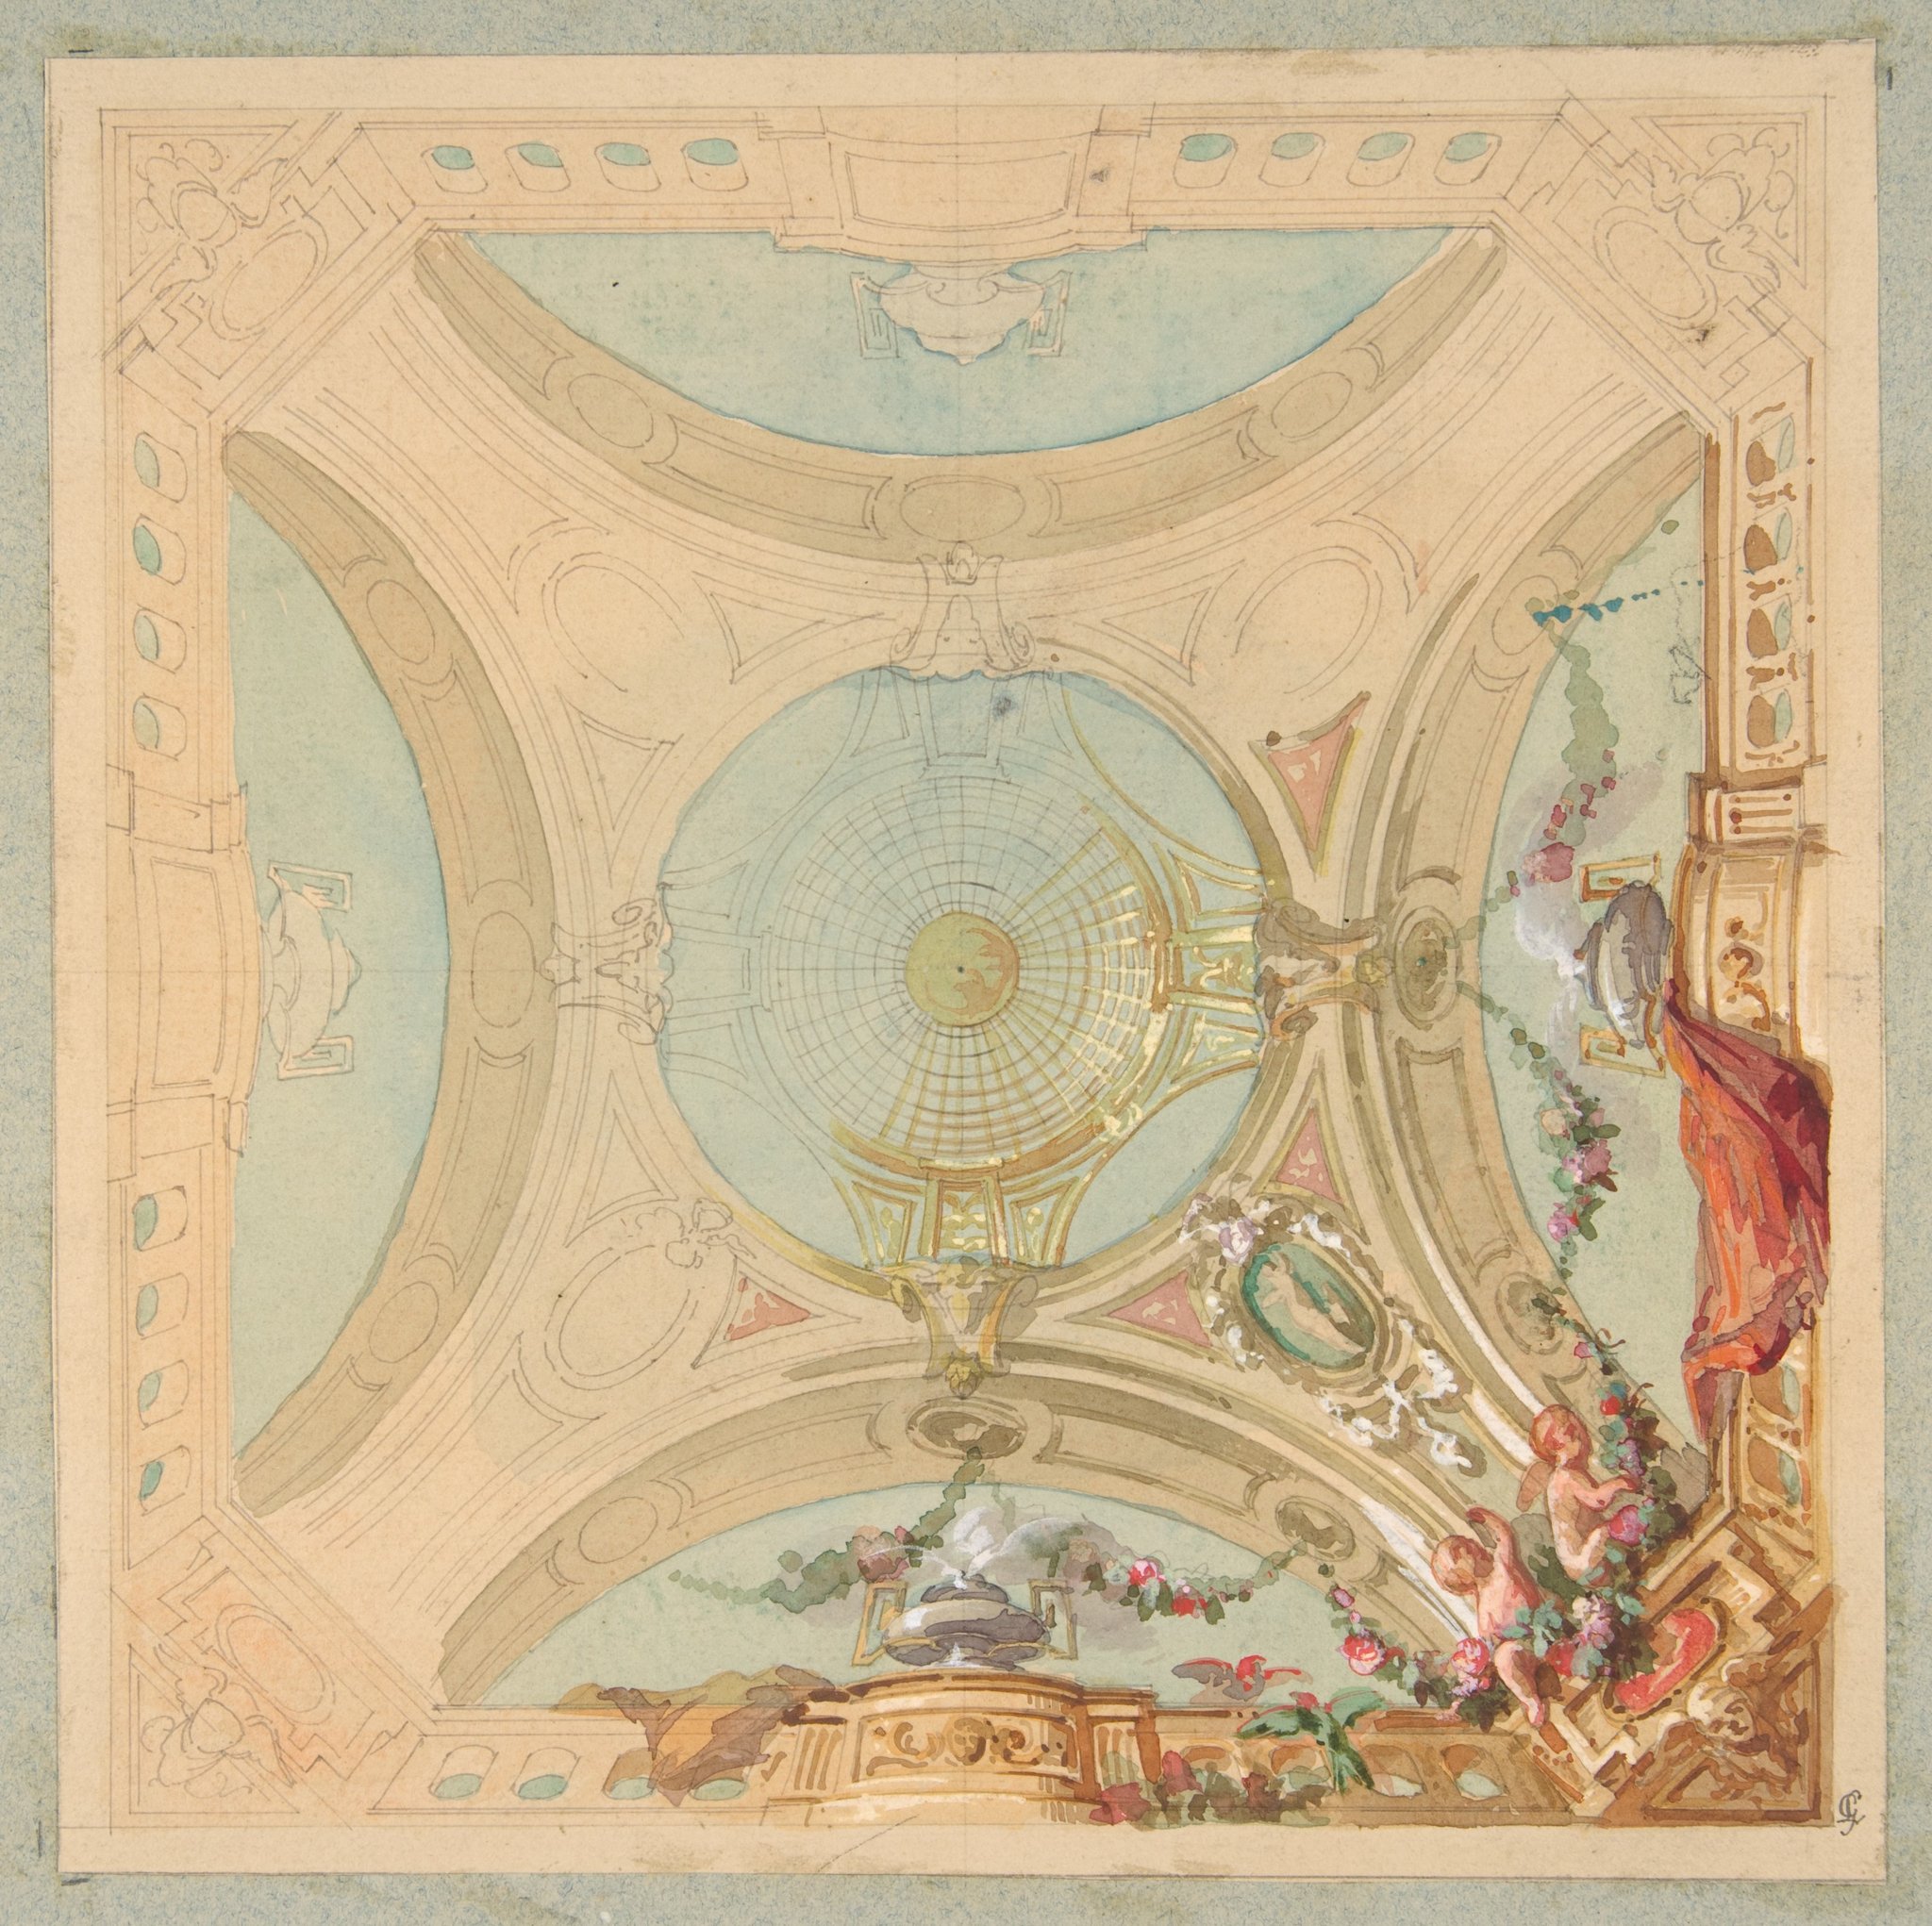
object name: drawing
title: Design for a ceiling with garland bearing putti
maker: jules-edmond-charles lachaise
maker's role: artist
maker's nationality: french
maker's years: 1897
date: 1851-1900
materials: gouache, graphite, watercolor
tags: garlands